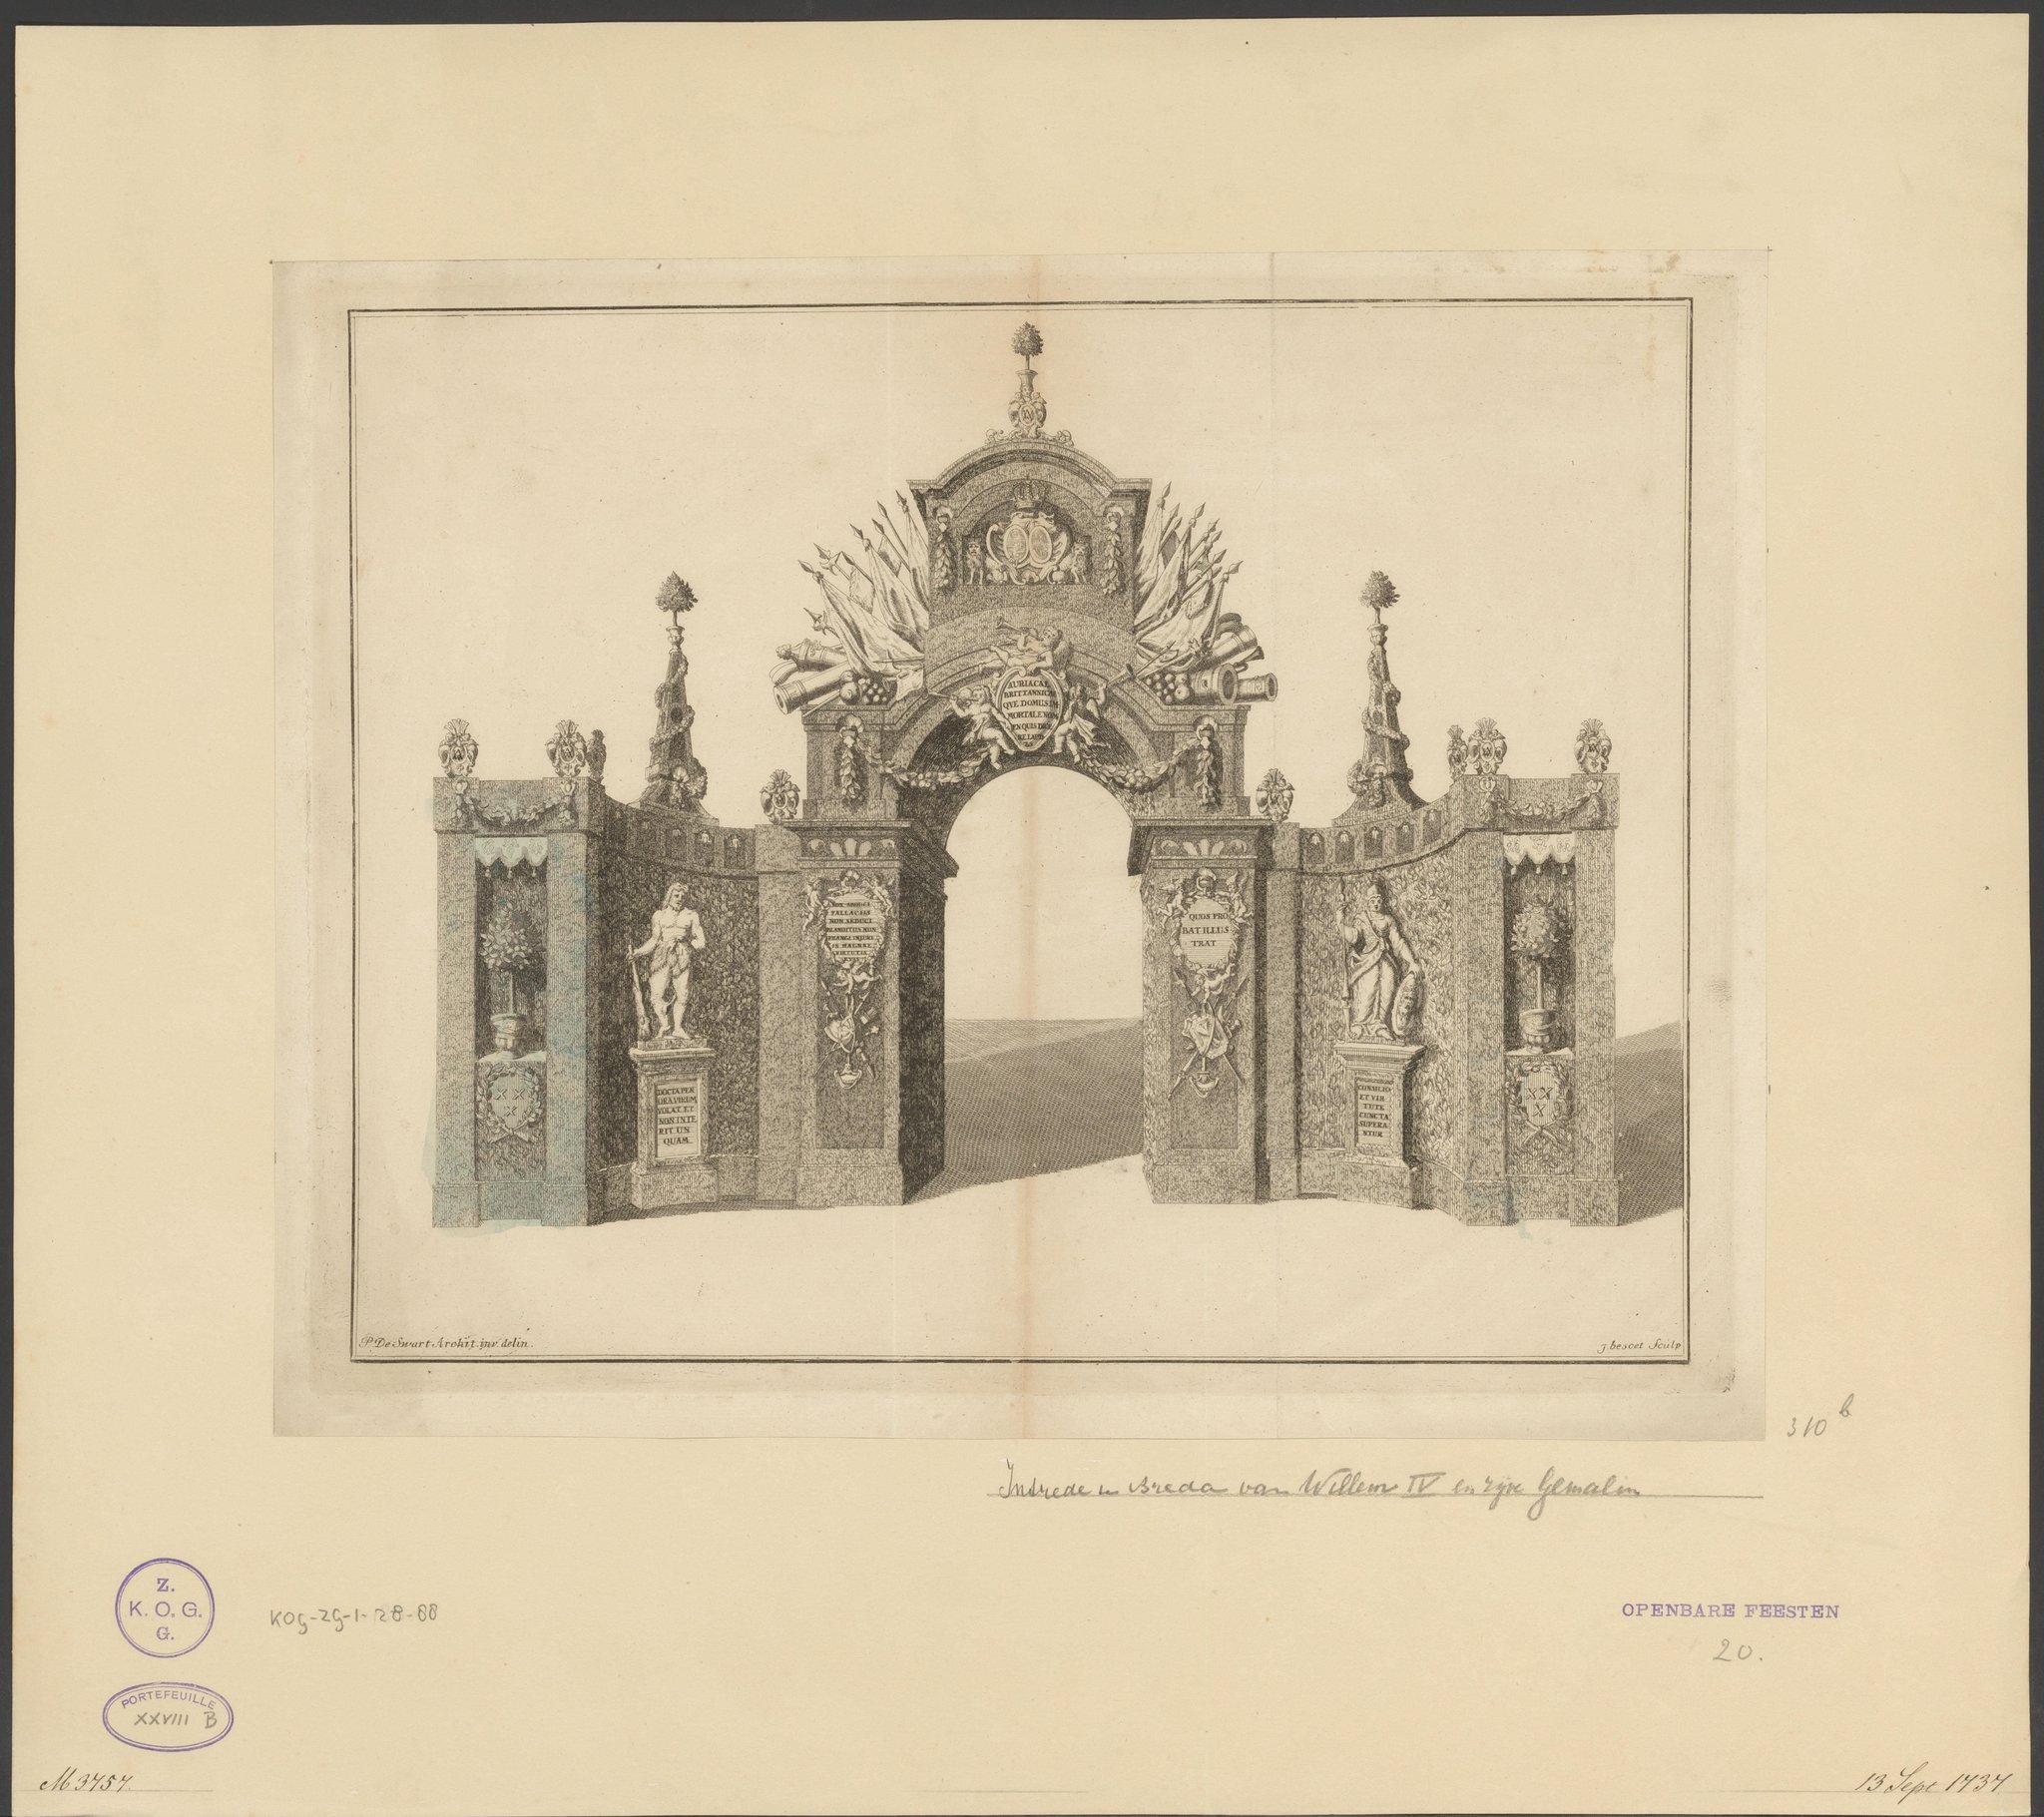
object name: print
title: Ereboog op het plein voor het Kasteel bij de intrede van Willem IV te Breda, 1737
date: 1737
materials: paper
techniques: etching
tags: willem iv (prins van oranje-nassau), anna van hannover, triumphal arch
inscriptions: collector's mark: Lugt 1641, stamp, stamp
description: Ereboog opgericht op het plein voor het Kasteel bij de intrede van Willem IV en zijn gemalin Anna van Hannover te Breda op 13 september 1737. De boog versierd met standbeelden, wapens en vaandels. In de ondermarge een handgeschreven opschrift in pen in bruin met een beschrijving van de poort. Onderwerpsrubrieken binnen de Atlas Zeden en Gewoonten: Zeden en Gewoonten in Engeren Zin. Volksleven. Openbare feesten. Vorstelijke intochten, (Illuminaties, vuurwerken en dergelijke, openbare feesten).